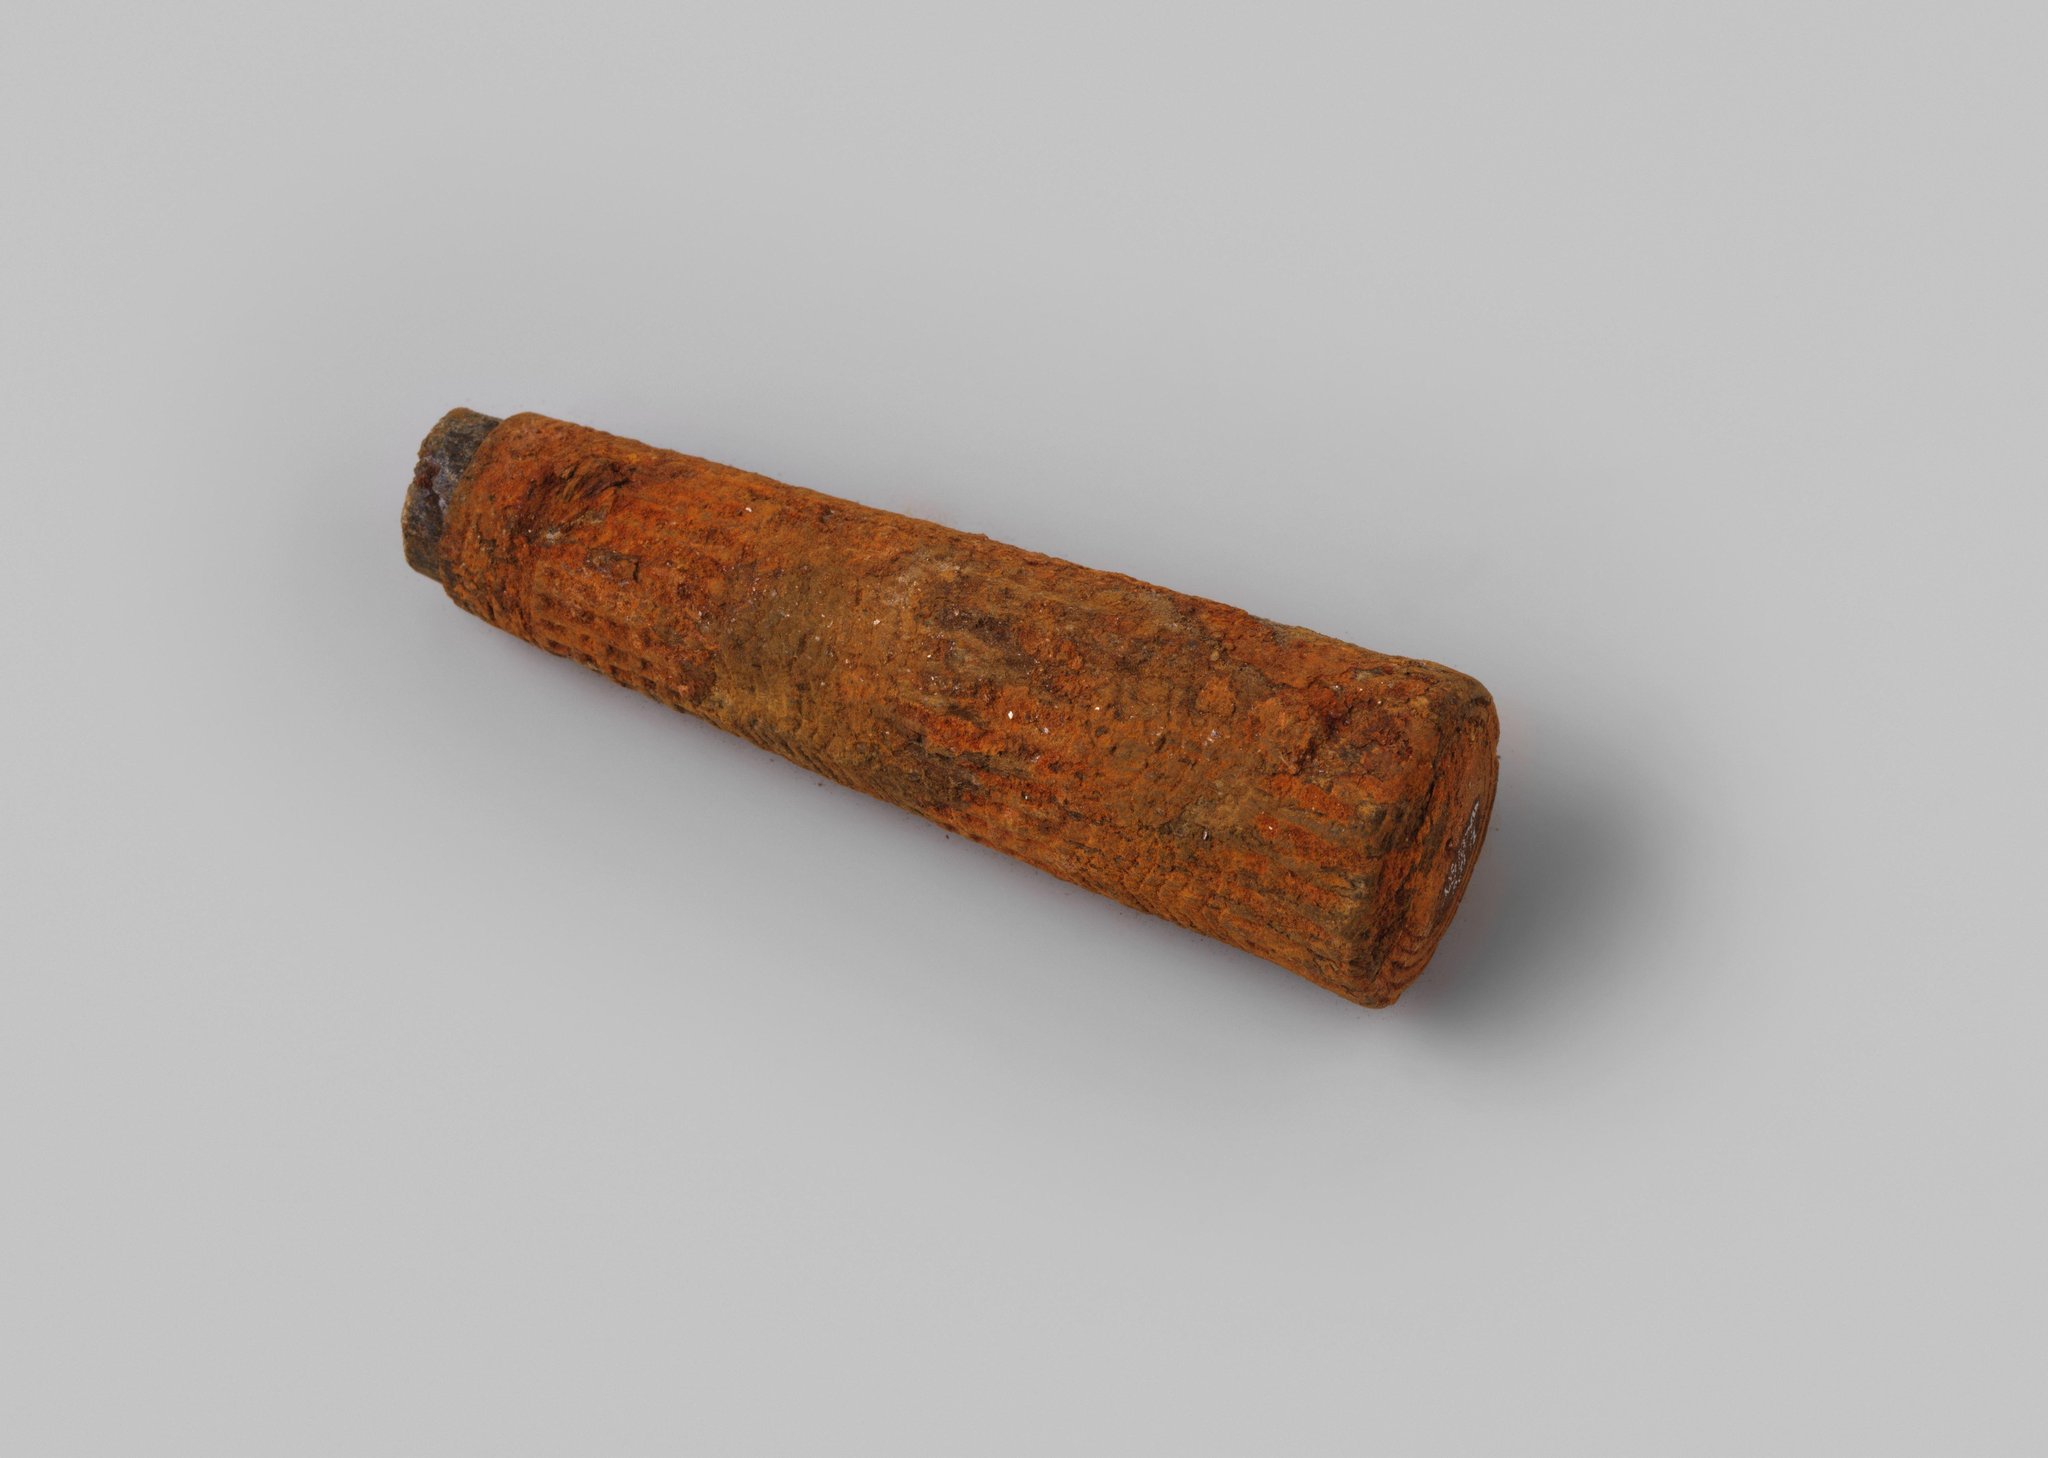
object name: knife handle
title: Messenheft uit het wrak van de Oost-Indiëvaarder Hollandia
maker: Anonymous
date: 1700-1743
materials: wood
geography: netherlands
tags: verenigde oostindische compagnie, hollandia (schip), annet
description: Knife, handle, cylindrical: tapering; id. NG 1979-403H, ferrules id. NG 1980-27H426.